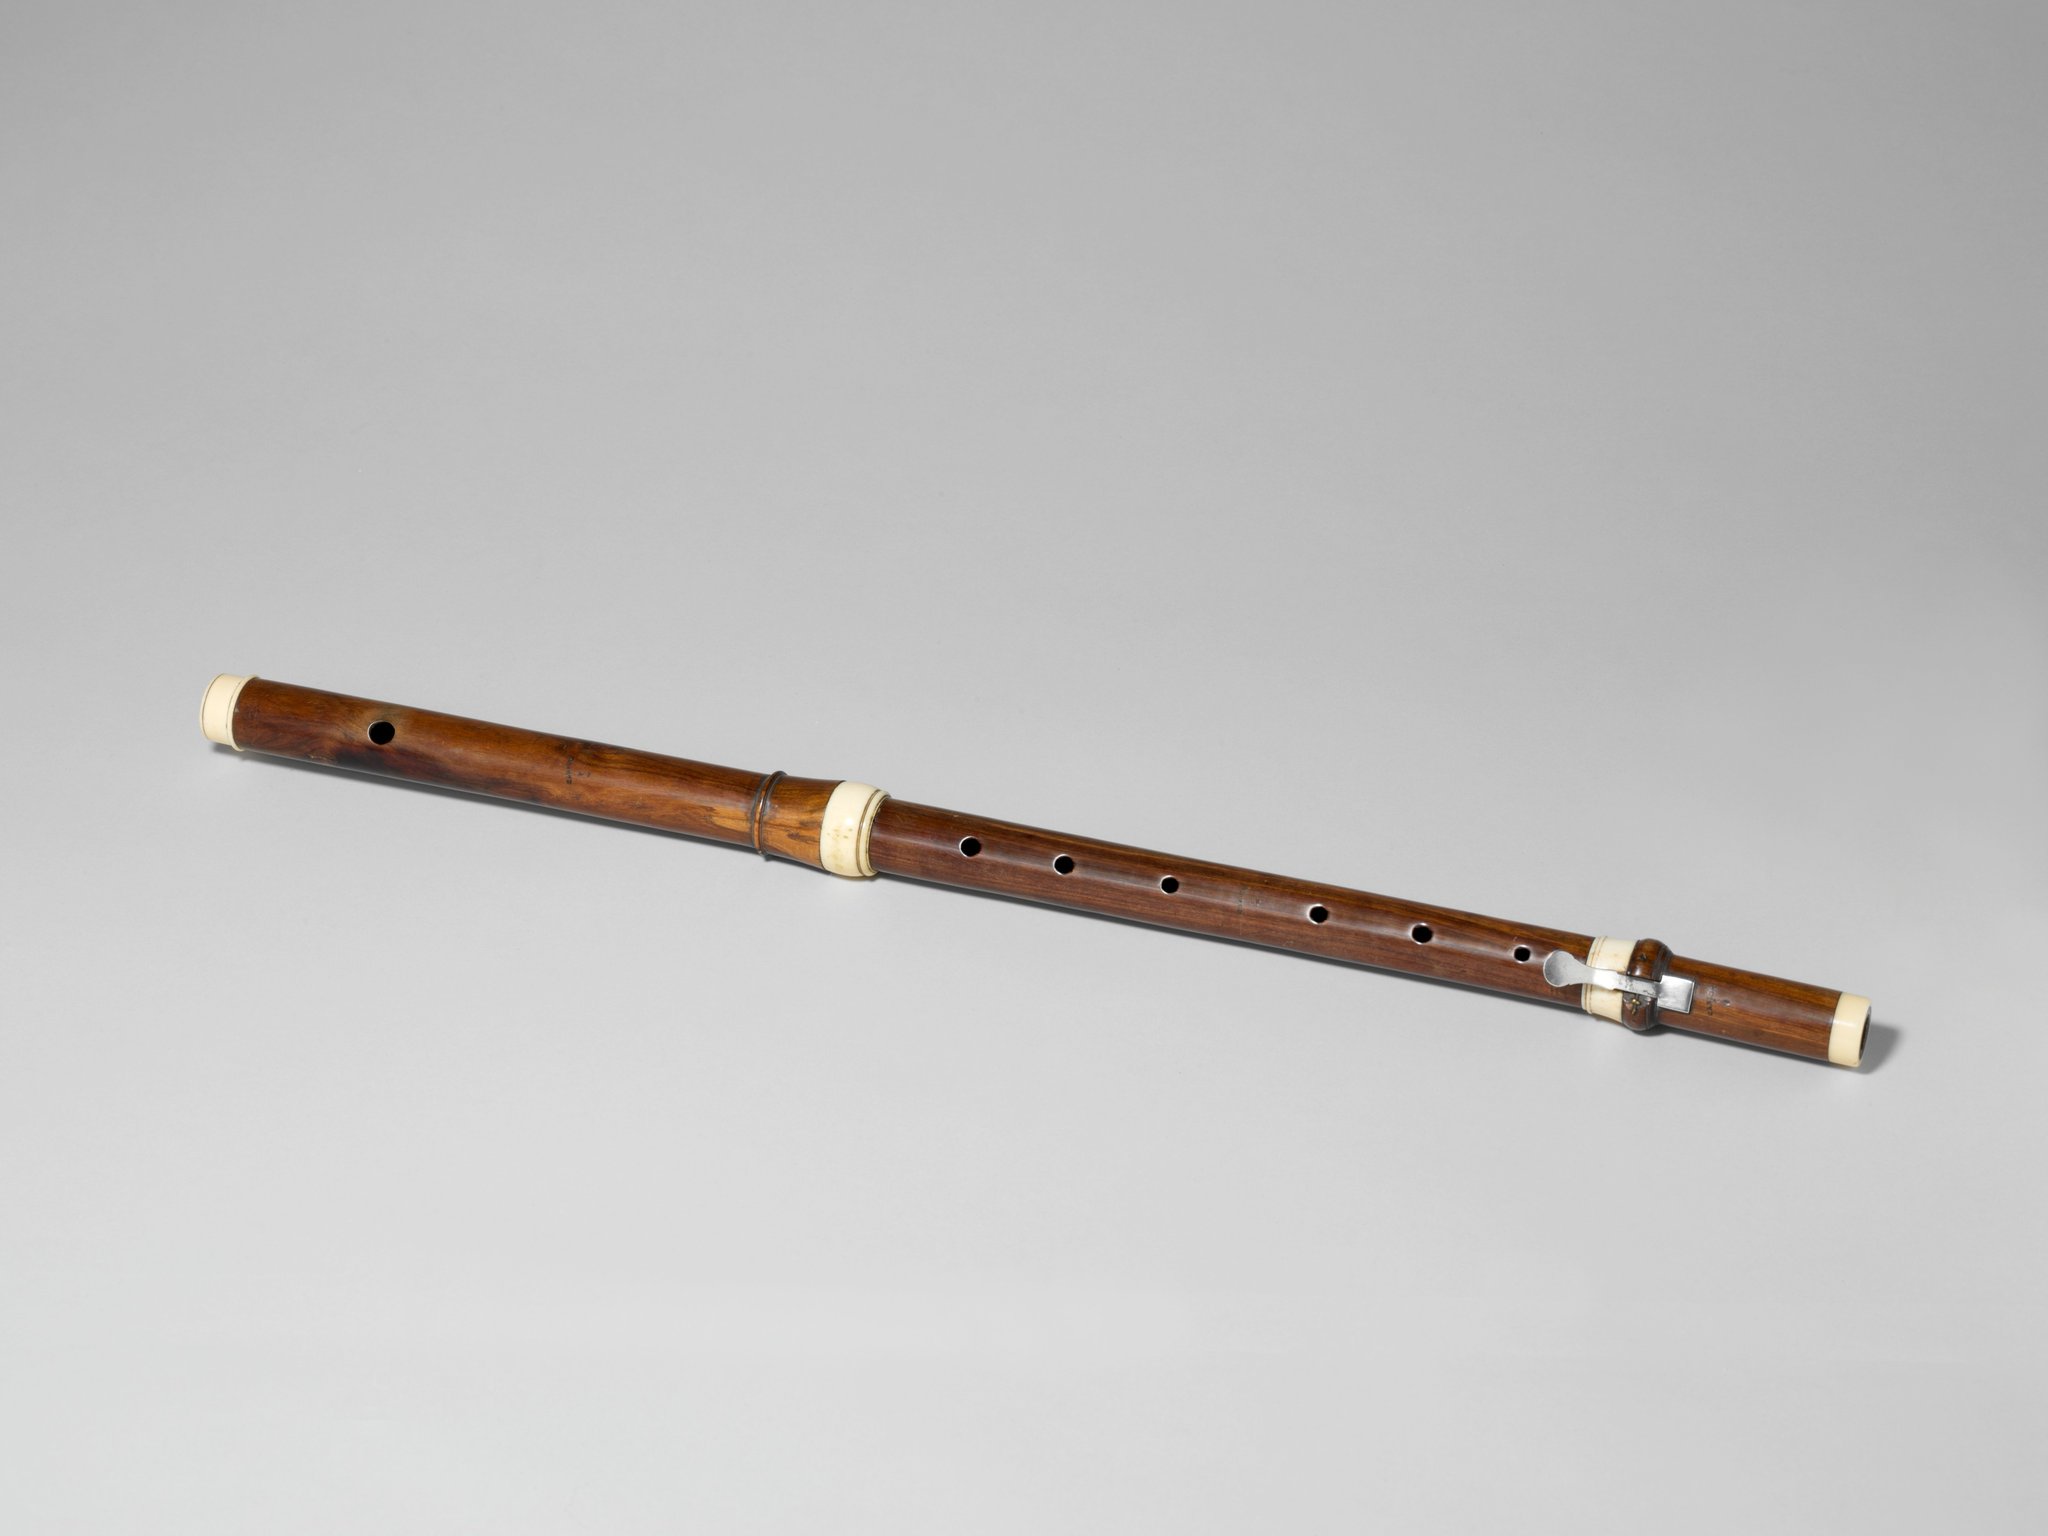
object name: transverse flute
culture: french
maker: garion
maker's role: manufacturer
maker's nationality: french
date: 1720-1740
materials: ivory, wood, silver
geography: france